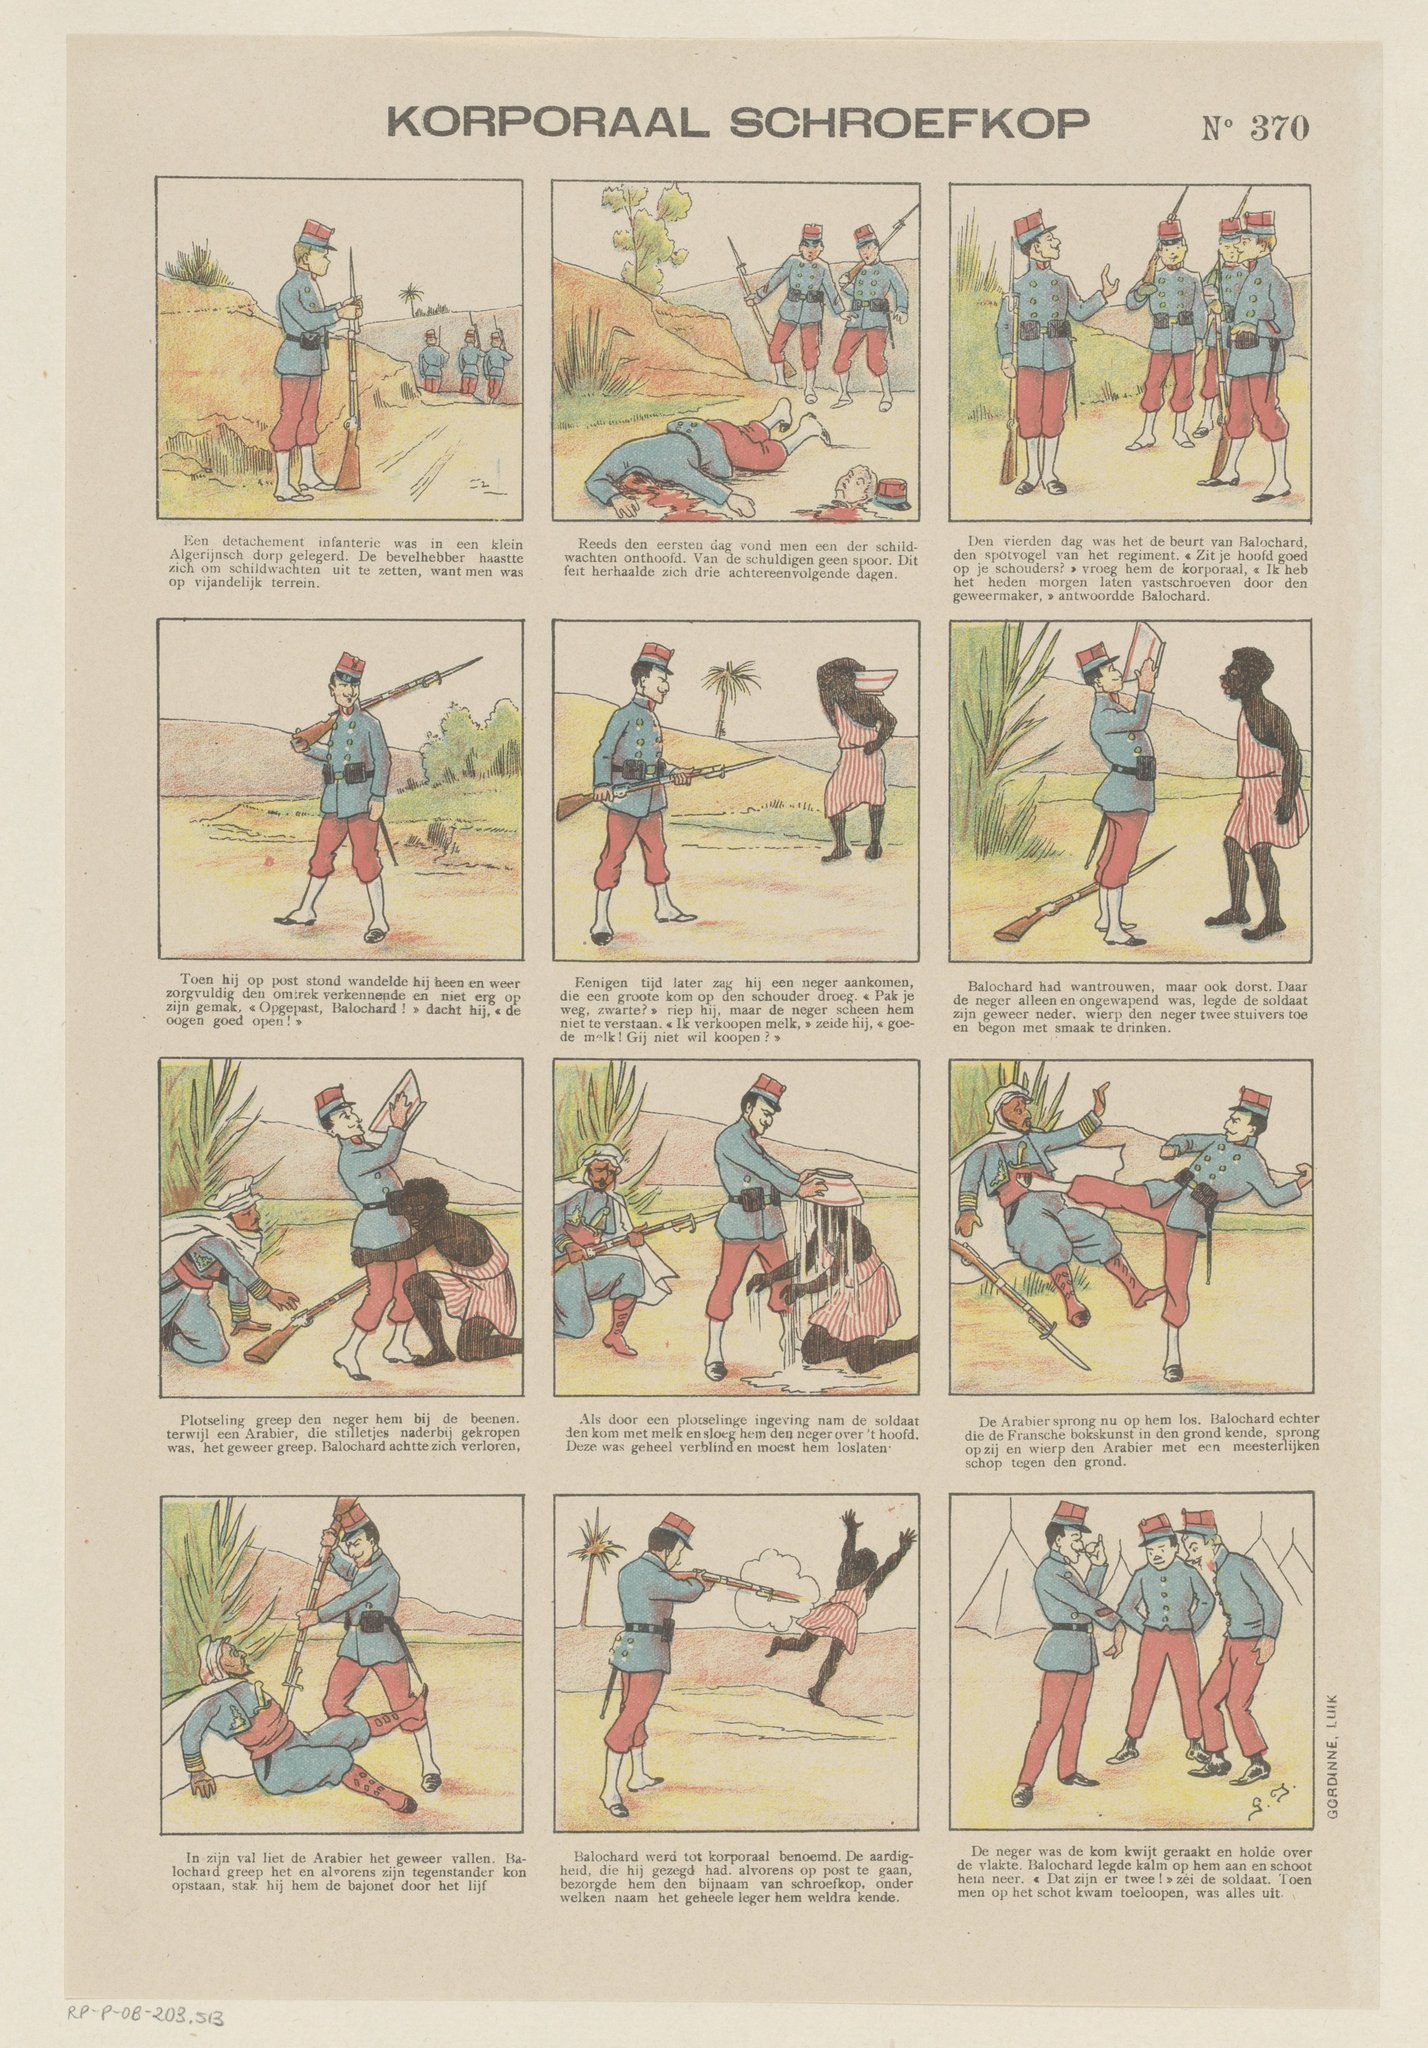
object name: popular print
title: Korporaal Schroefkop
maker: monogrammist g.j.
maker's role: print maker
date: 1894-1959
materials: paper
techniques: lithograph, letterpress printing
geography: liège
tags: the soldier; the soldier's life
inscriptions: collector's mark: Lugt 2760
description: Blad met 12 voorstellingen over Balochard, de spotvogel van het regiment, die de list van de zwarte man en de Arabier overleeft. Onder elke afbeelding een onderschrift. Genummerd rechtsboven: No 370.